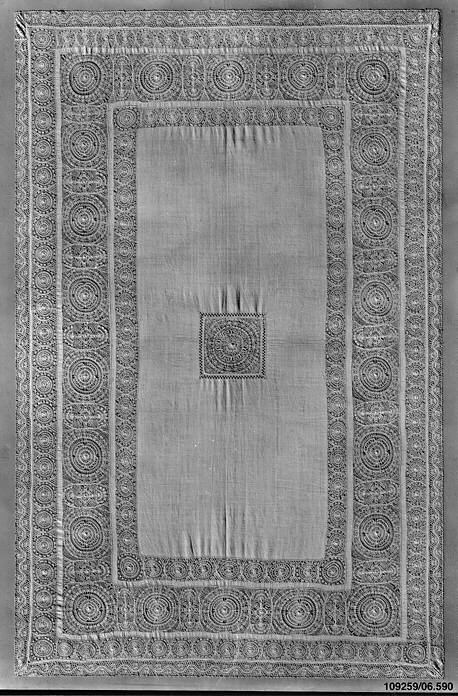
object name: cover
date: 1601-1700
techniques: embroidery